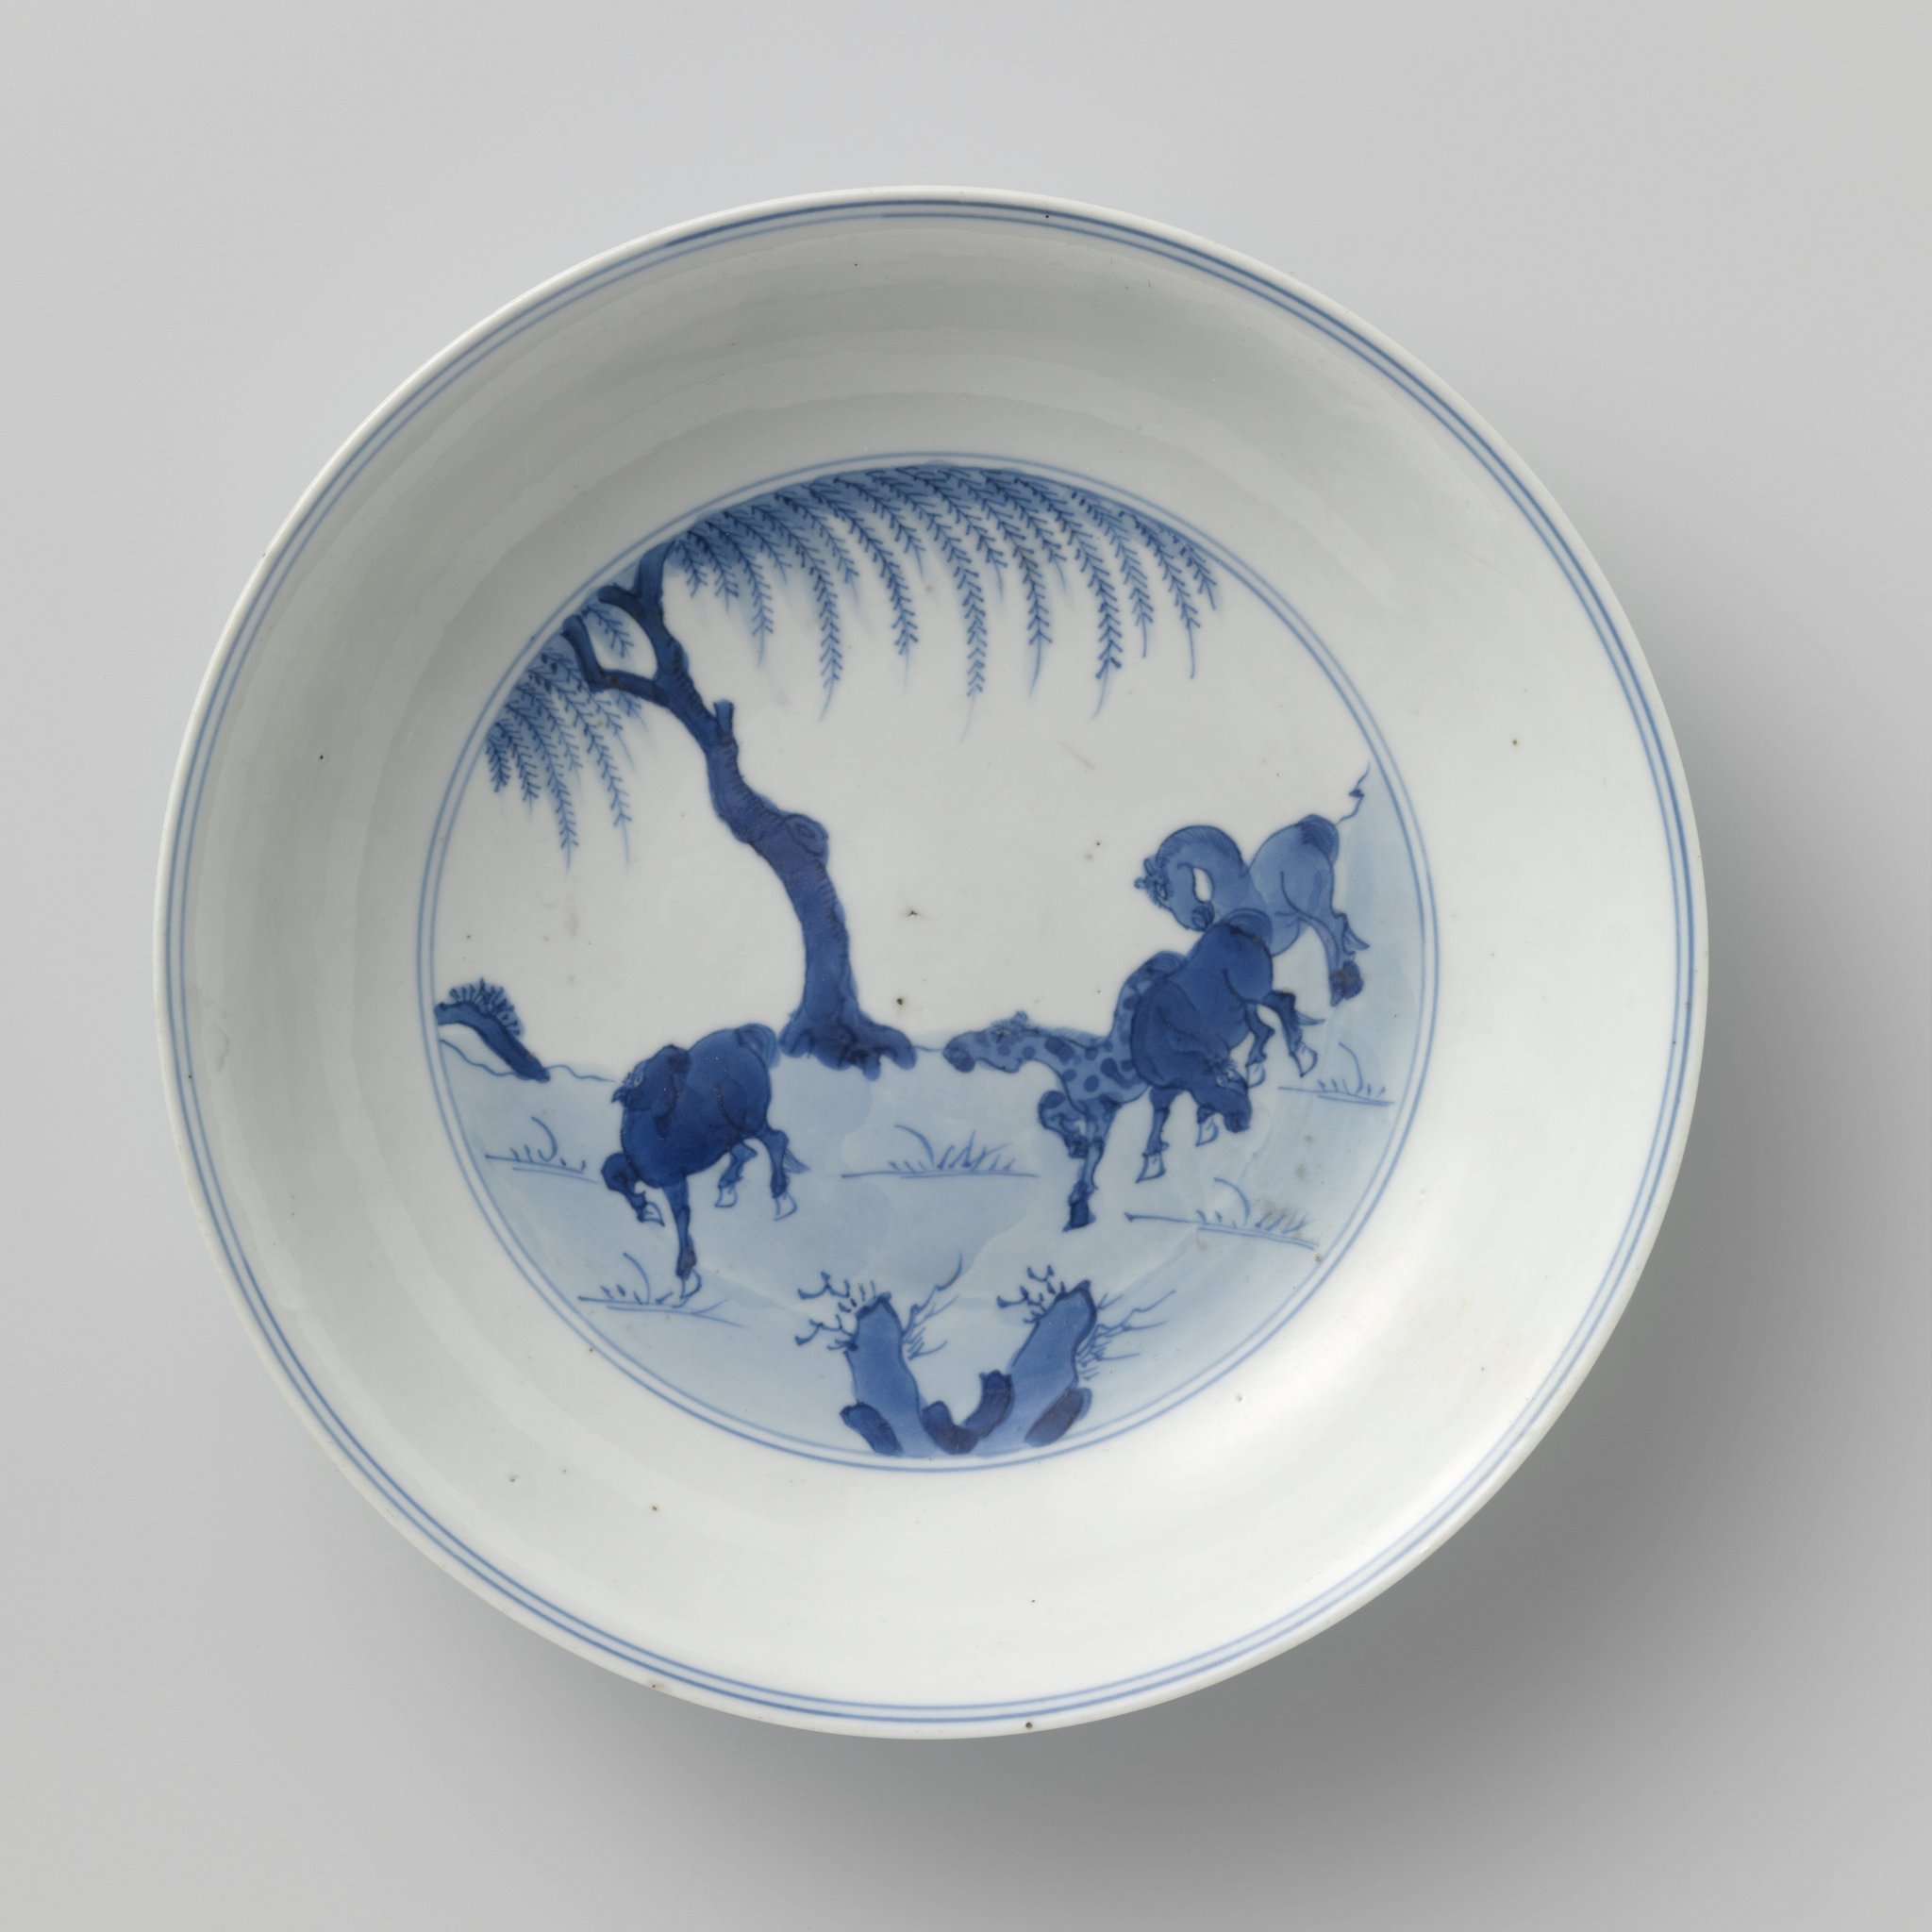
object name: dish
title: Saucer-dish with horses in a landscape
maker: Anonymous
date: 1680-1720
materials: cobalt, glaze, paint, porcelain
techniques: firing, turning, vitrification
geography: china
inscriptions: mark: ‘大 明 成 化 年 製’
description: Schaal van porselein met ronde wand, beschilderd in onderglazuur blauw. Op het plat vier paarden in een landschap met rotsen en een boom; de achterzijde met vier galopperende paarden in een landschap met rotsen en een boom. Gemerkt op de onderzijde met het zes-karaktermerk van keizer Chenghua in een dubbele cirkel. Blauw-wit.